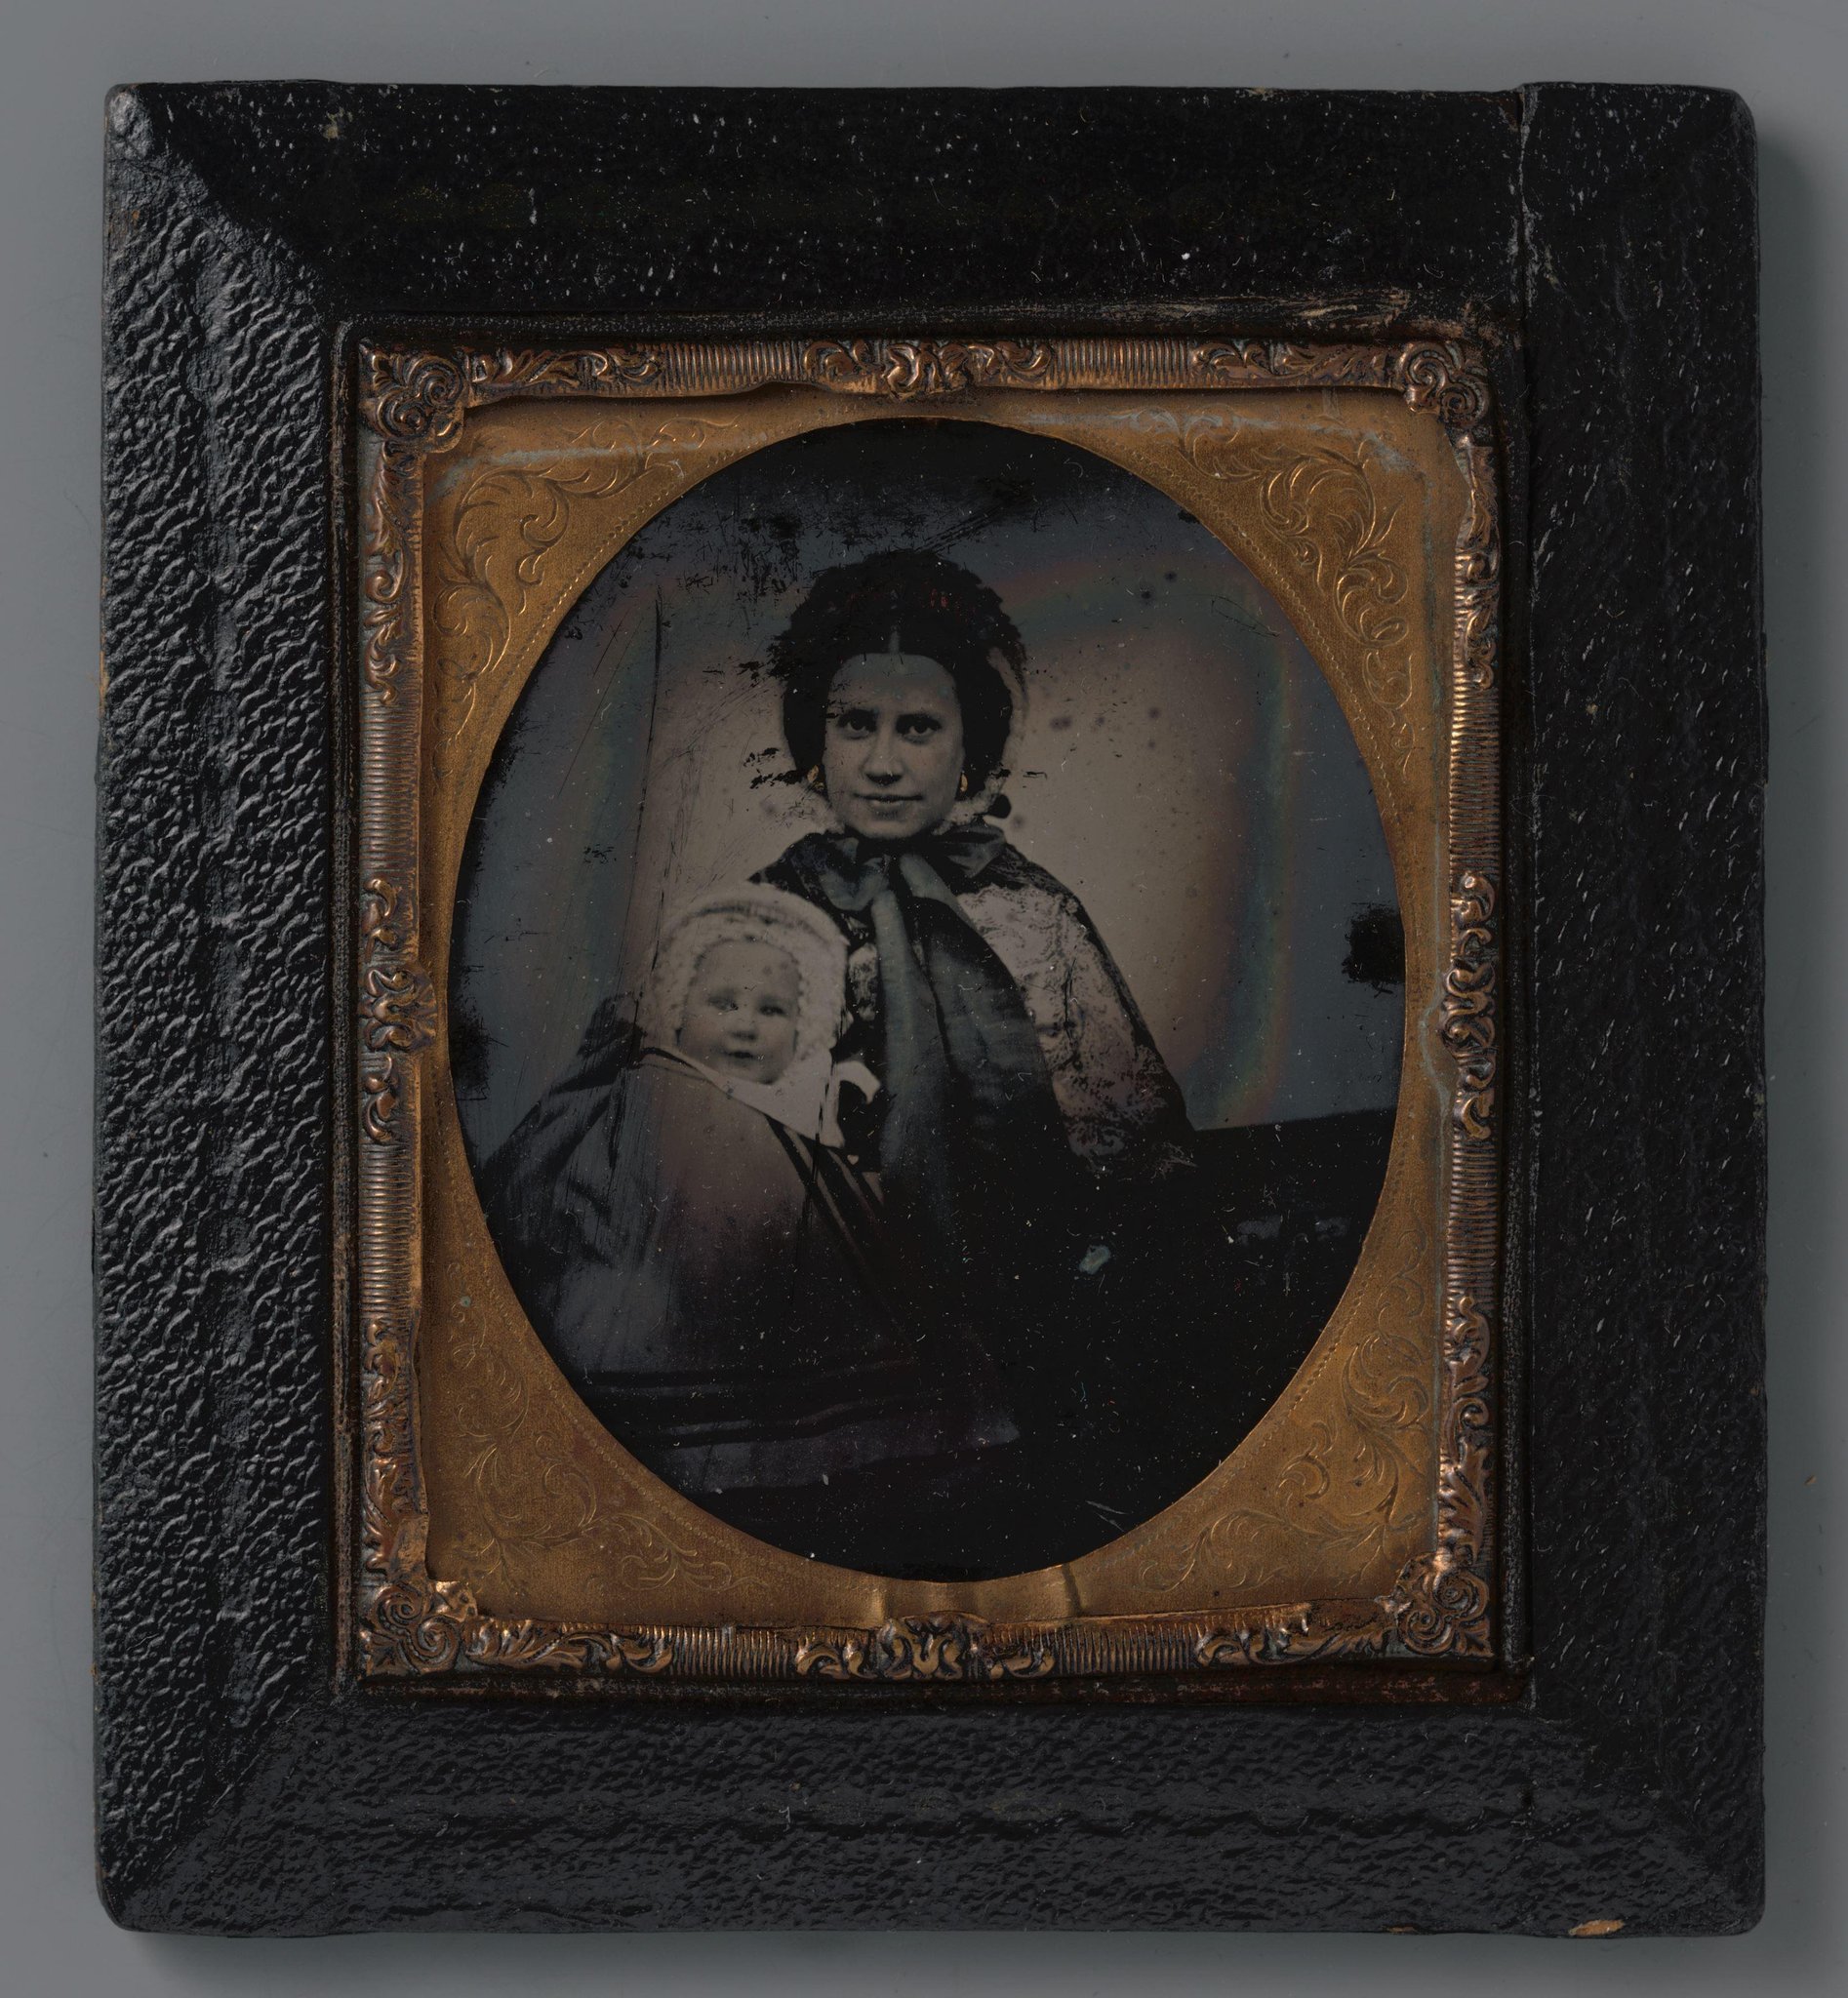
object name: frame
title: Portret van een onbekende vrouw met kind op schoot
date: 1855-1870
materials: glass, metal, wood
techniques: ambrotype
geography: london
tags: historical persons - bb - woman, toddler (female), mother and baby or young child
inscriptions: inscription: ‘Covell's , no 86. Whitechapel Road London etc.’